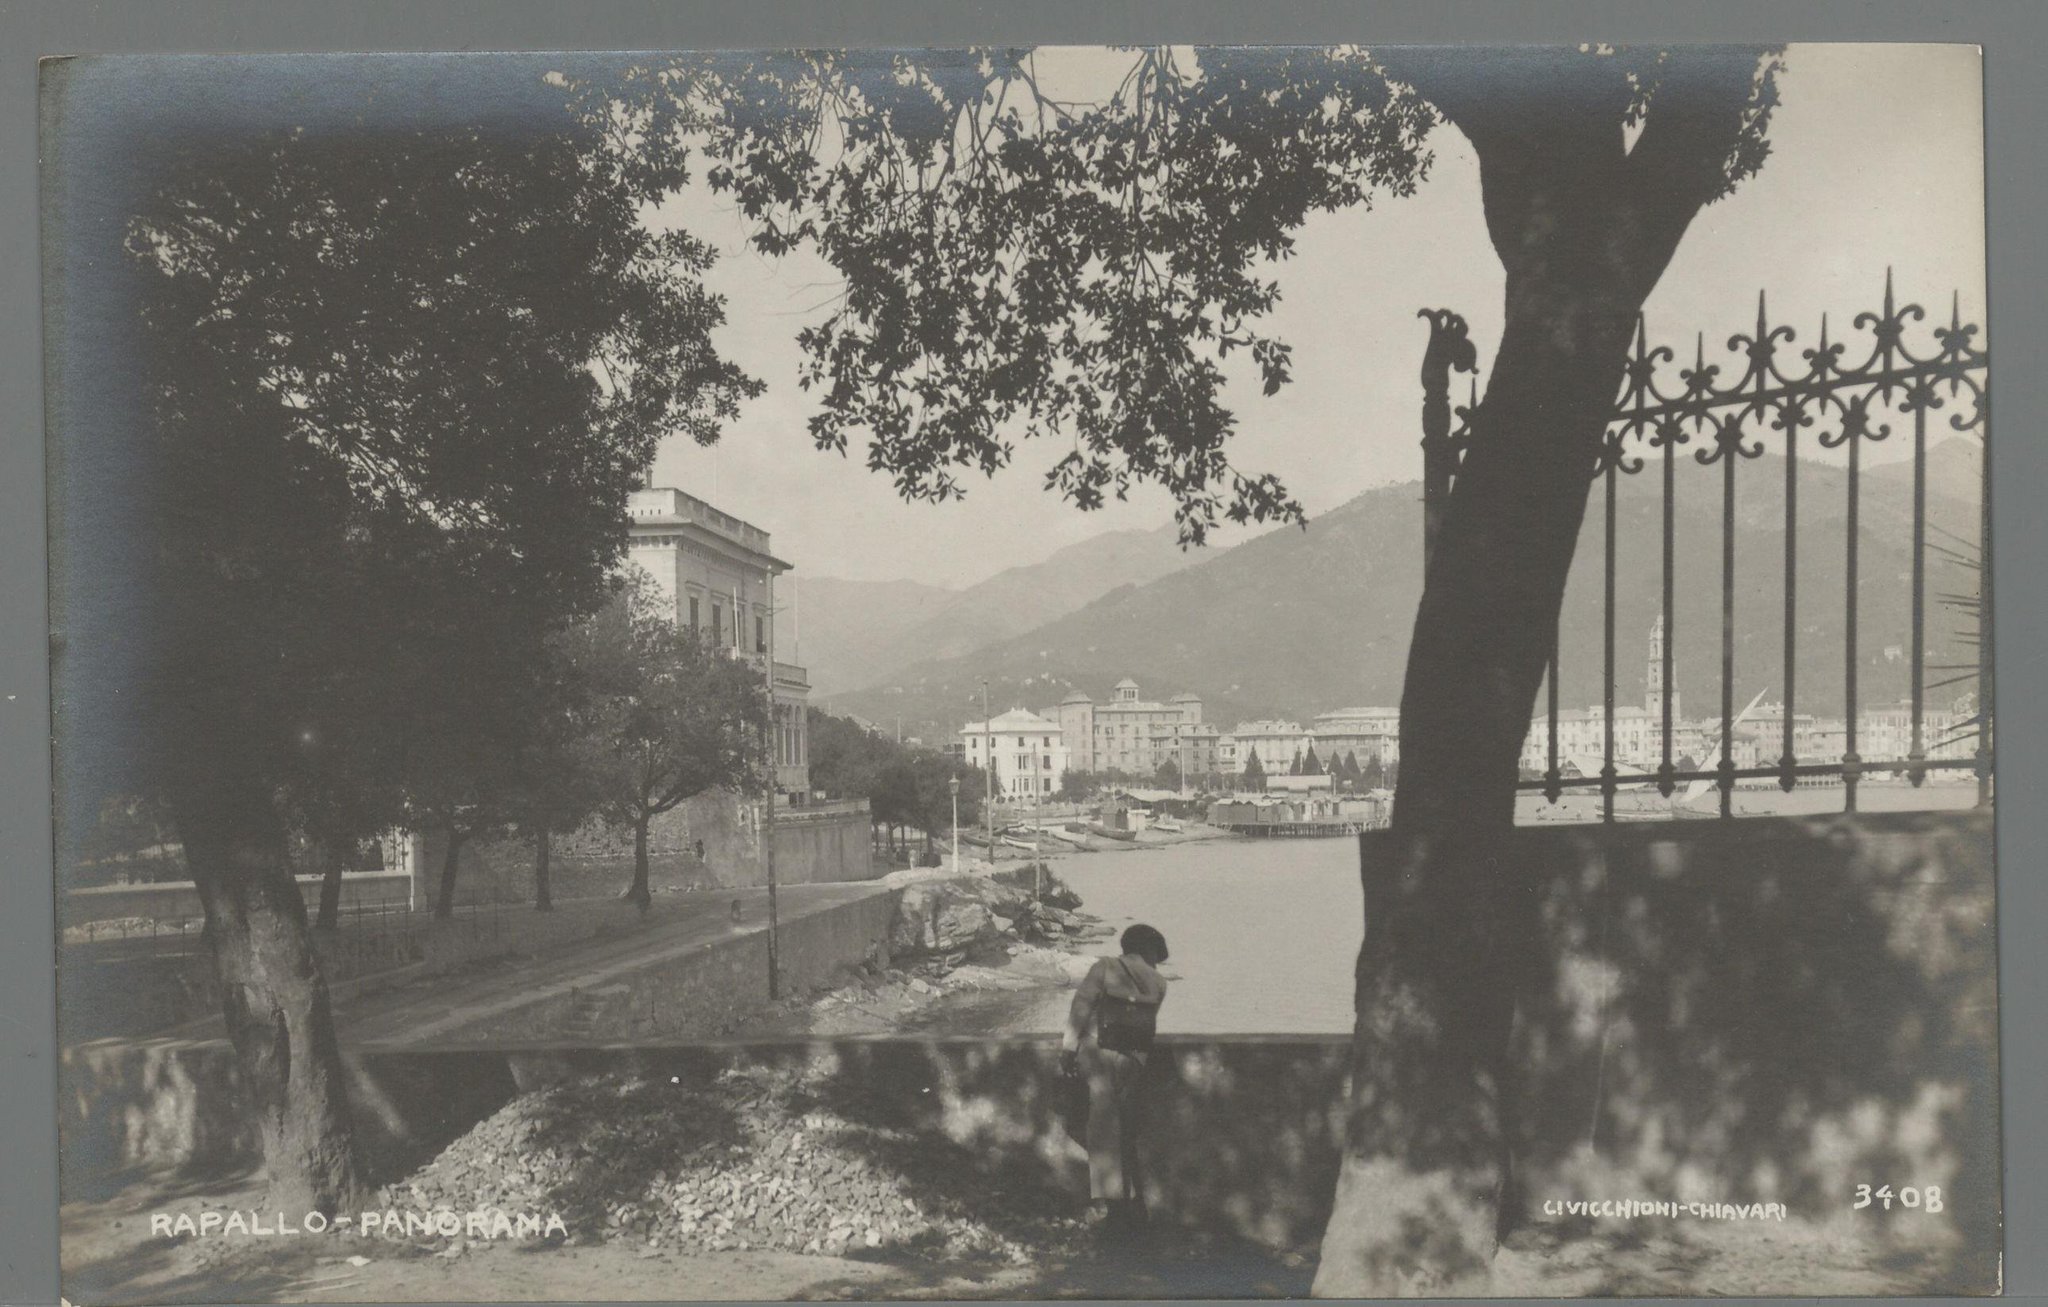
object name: photograph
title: Rapallo. Panorama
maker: Anonymous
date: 1906-1909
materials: photographic support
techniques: photography, writing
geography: chiavari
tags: harbour, city-view, and landscape with man-made constructions (+ city(-scape) with figures, staffage)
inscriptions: mark